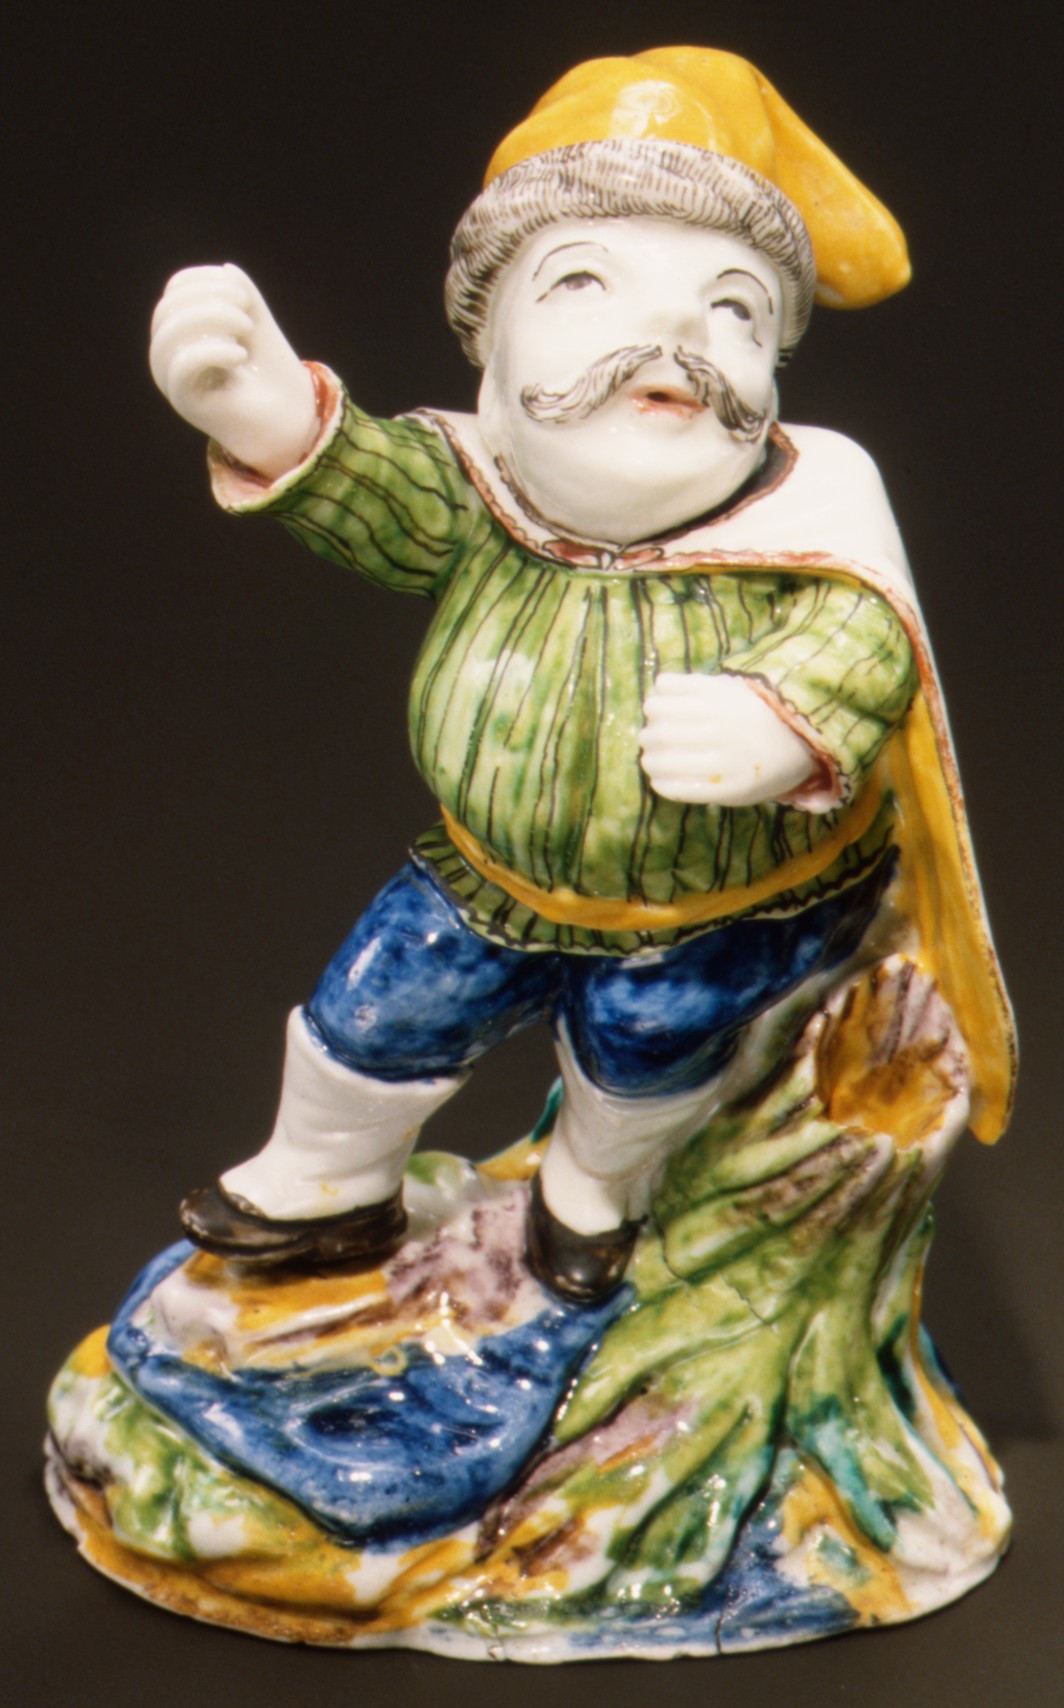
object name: figure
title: Hussar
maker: villeroy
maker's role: factory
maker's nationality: french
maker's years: 1734-1748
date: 1740-1745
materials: soft paste porcelain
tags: men